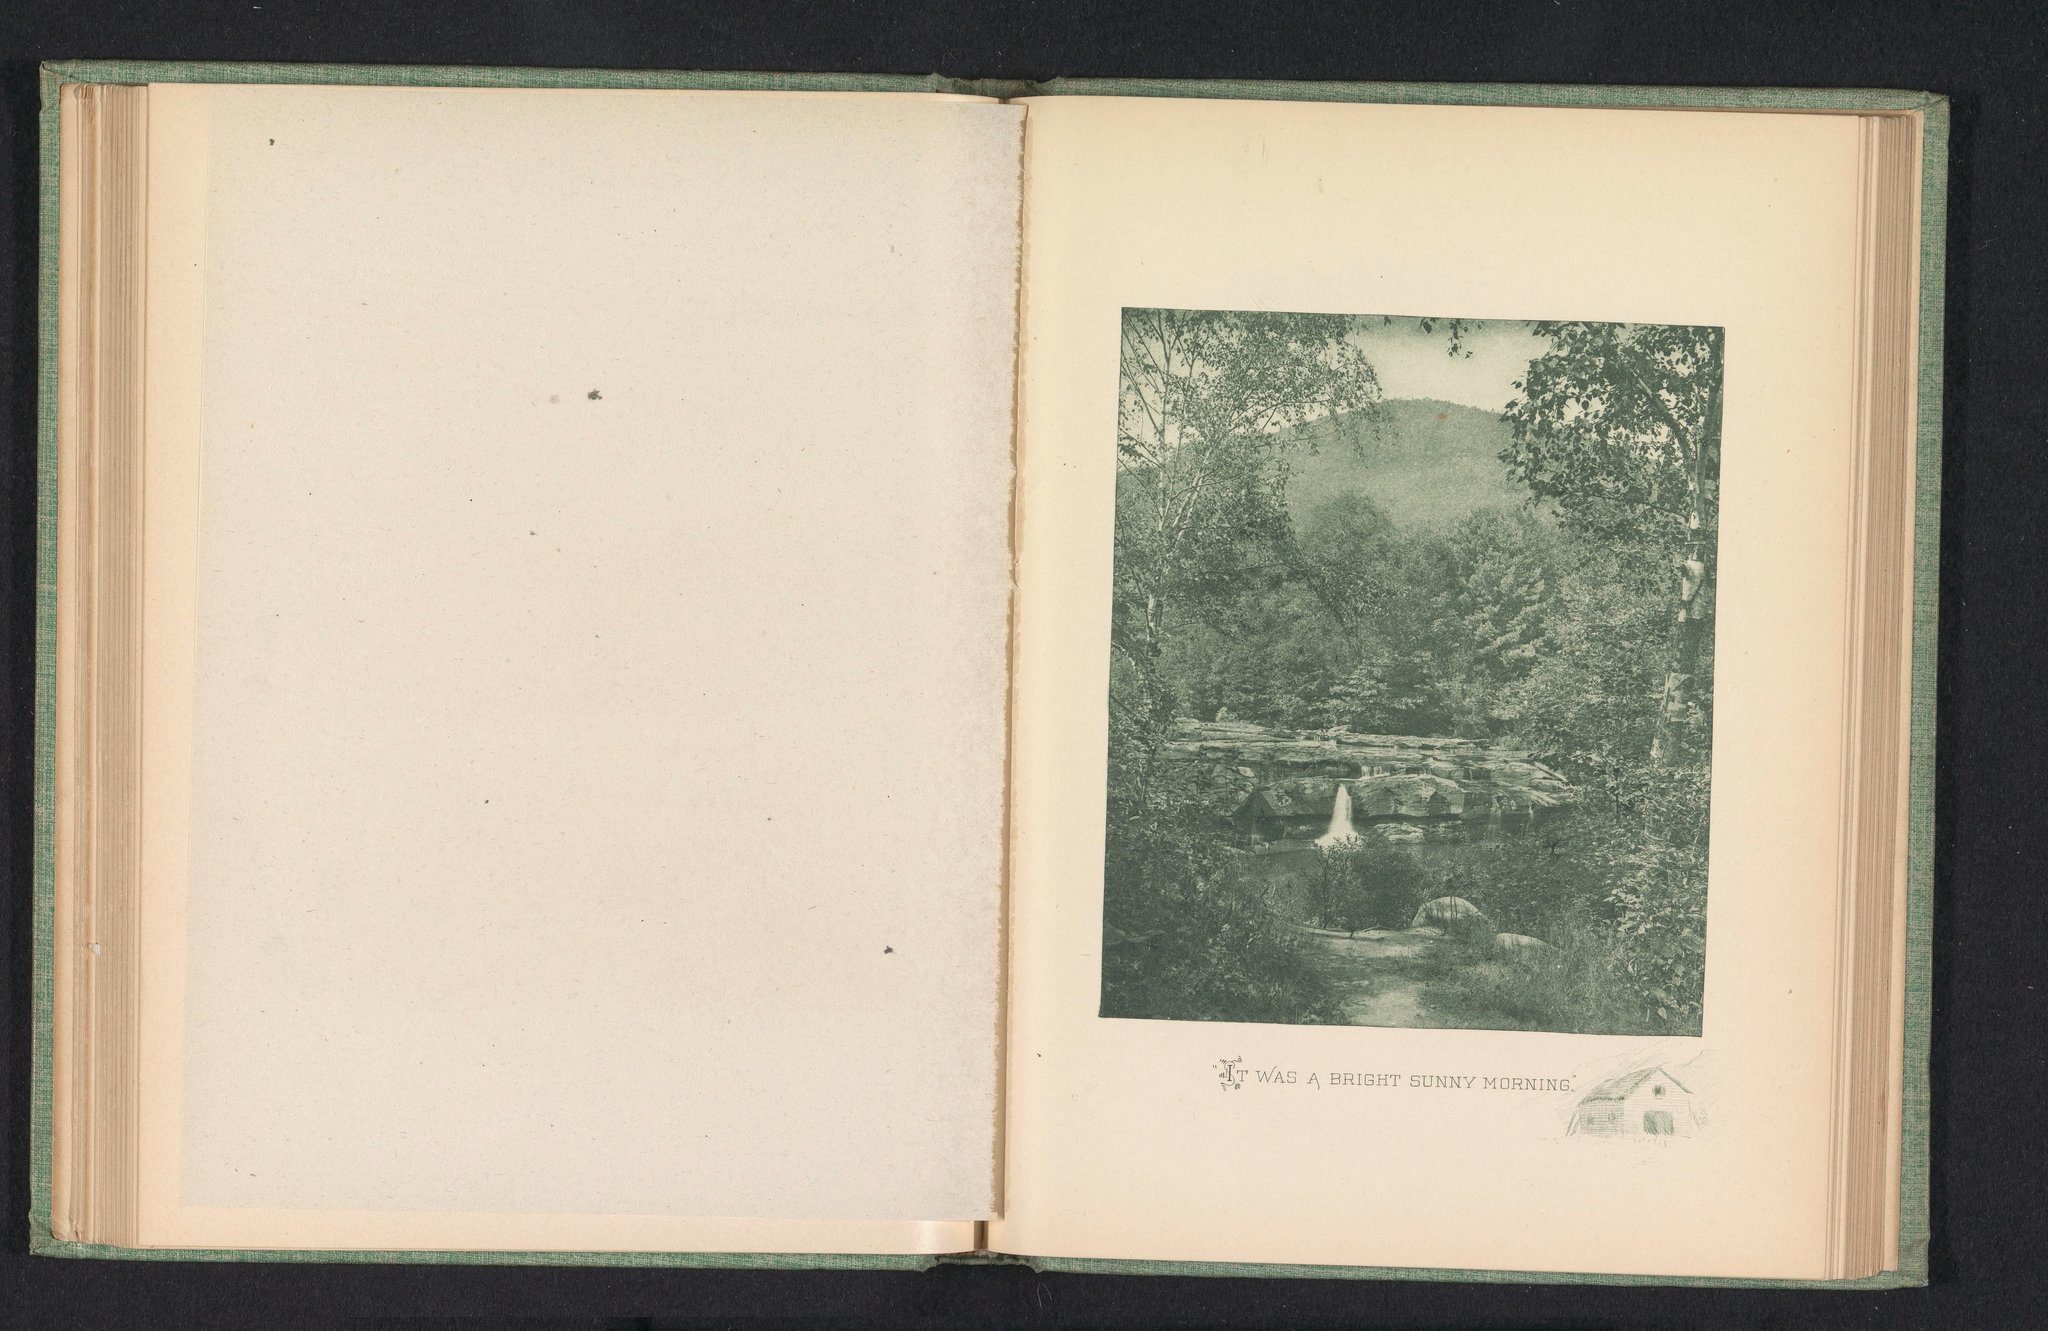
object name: photomechanical print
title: Gezicht op bergen, een rivier en een kleine waterval in het Catskillgebergte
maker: Anonymous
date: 1884-1894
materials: paper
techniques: photoaquatint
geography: catskill mountains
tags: river, waterfall, mountains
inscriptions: inscription: ‘“It was a brught sunny morning”’